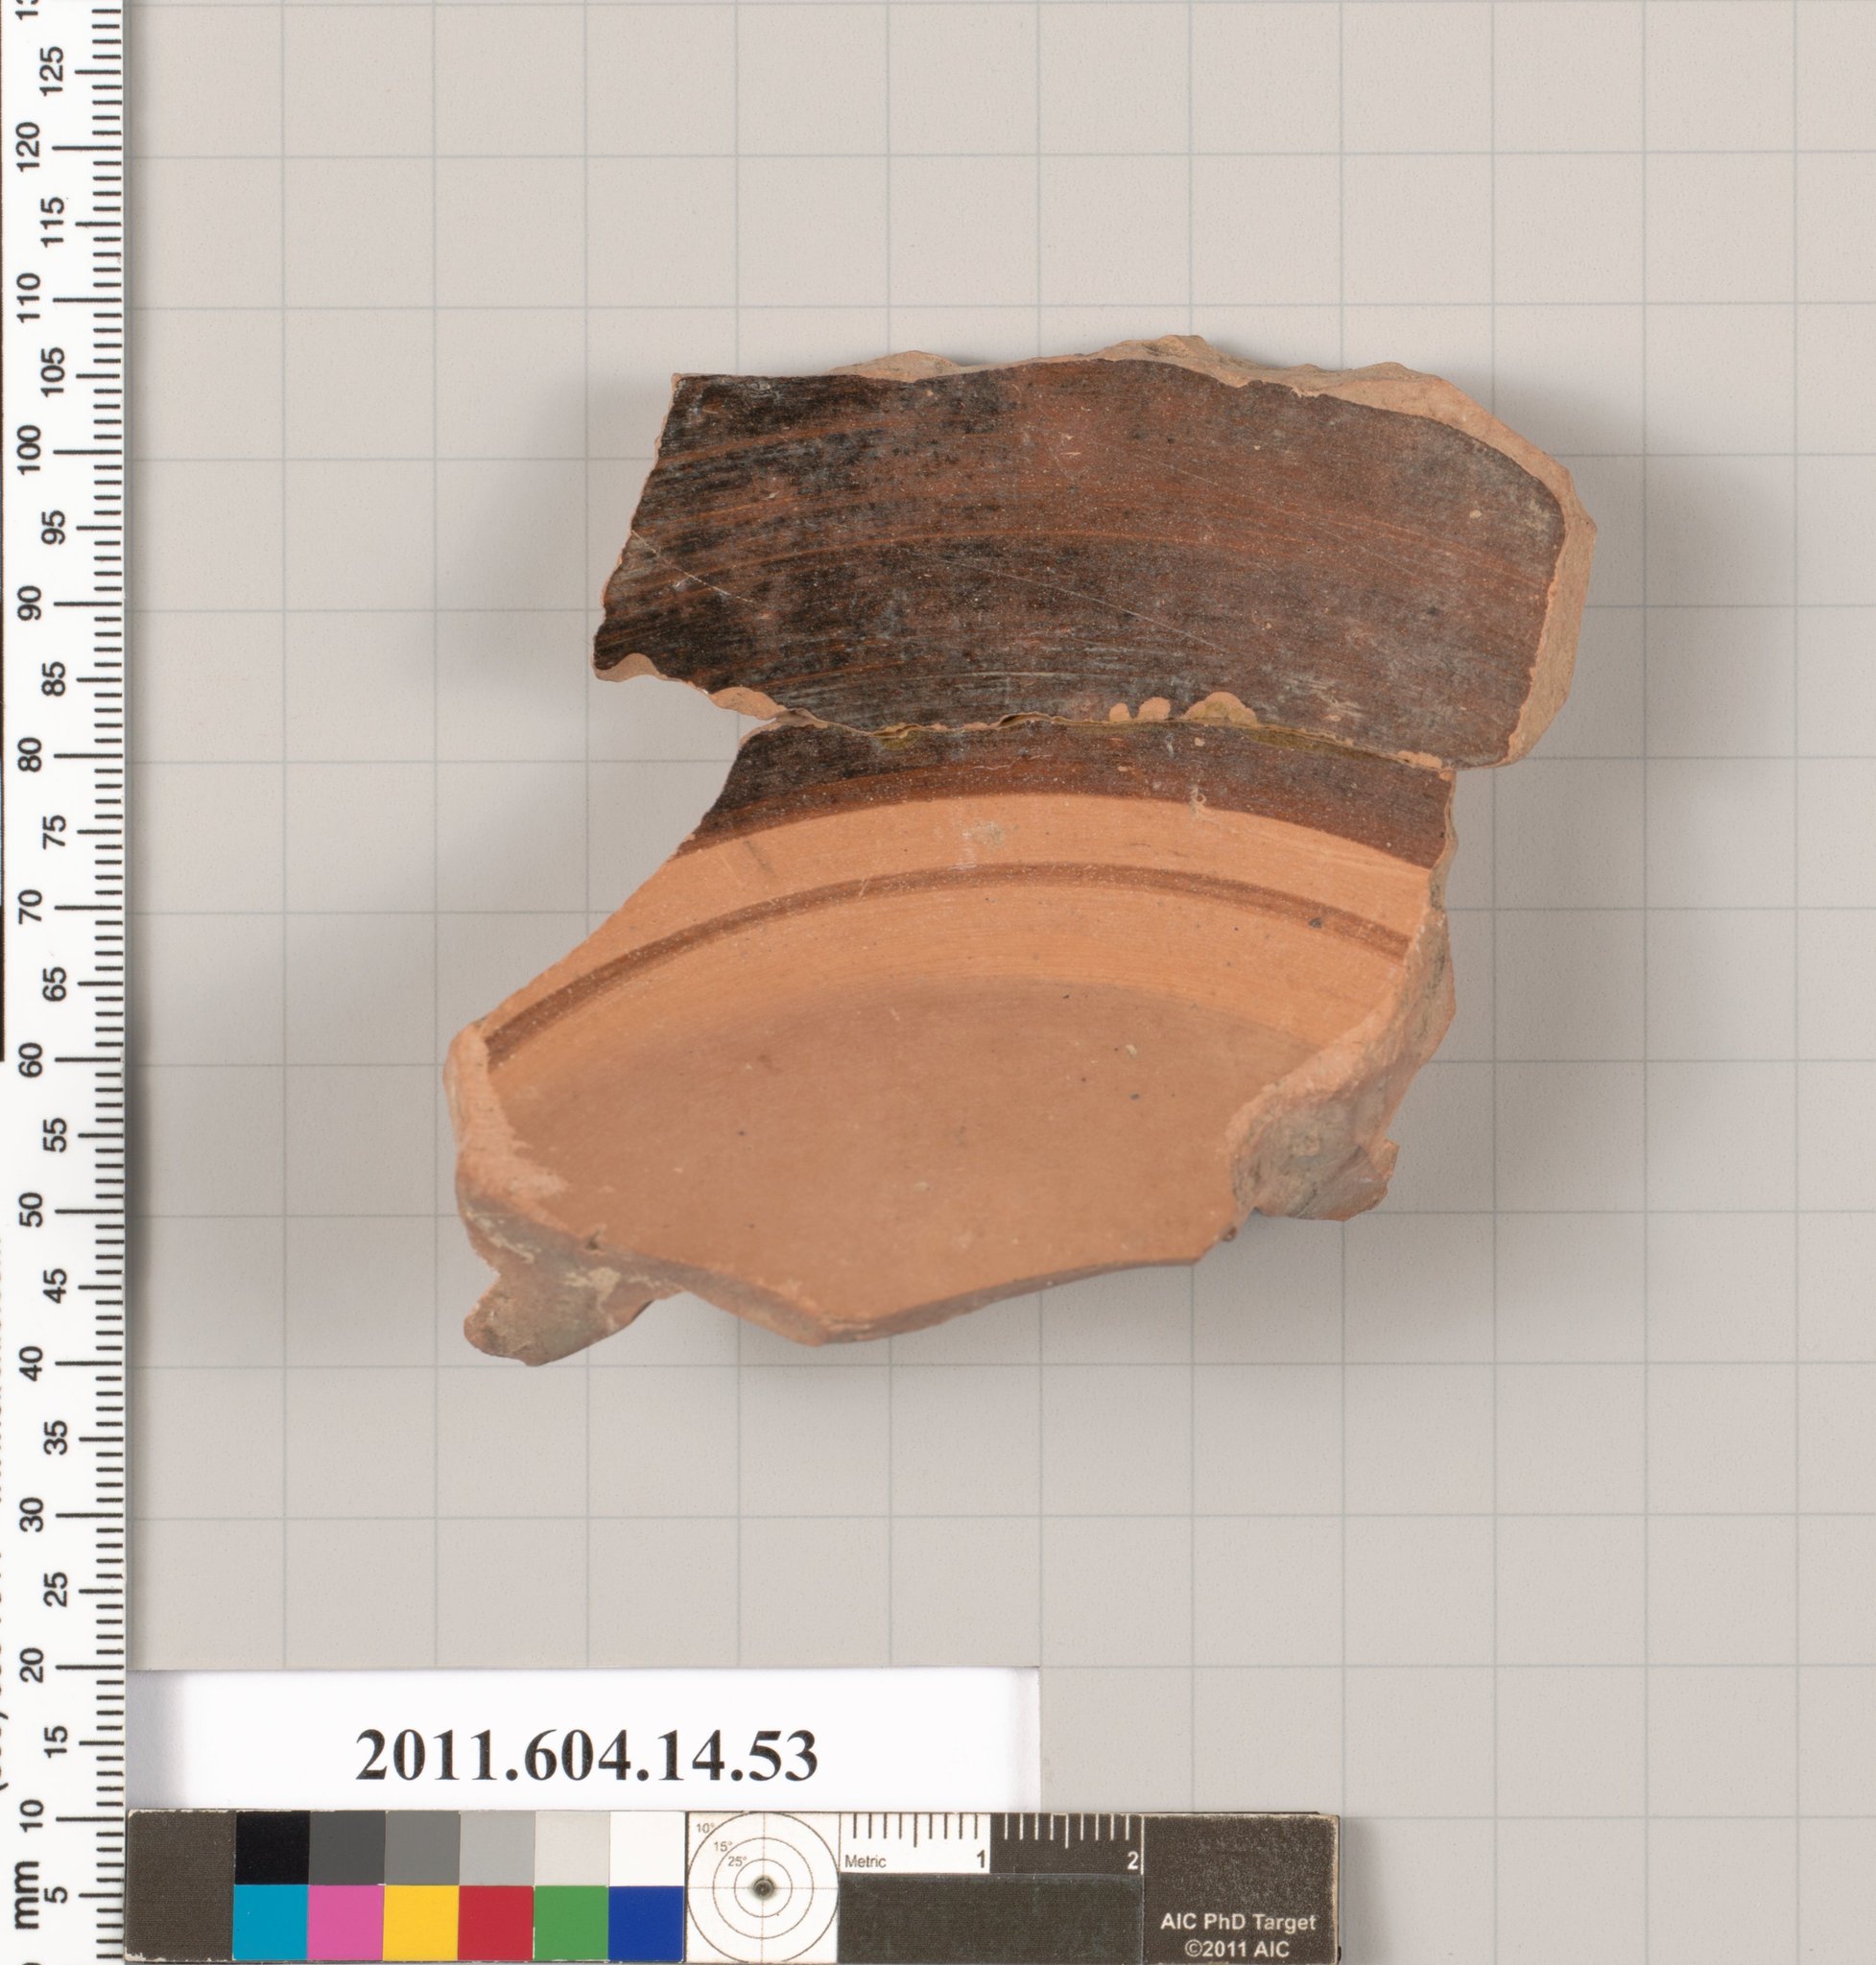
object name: fragment of a bowl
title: Terracotta fragment of a bowl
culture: unknown fabric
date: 600-301 BCE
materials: terracotta